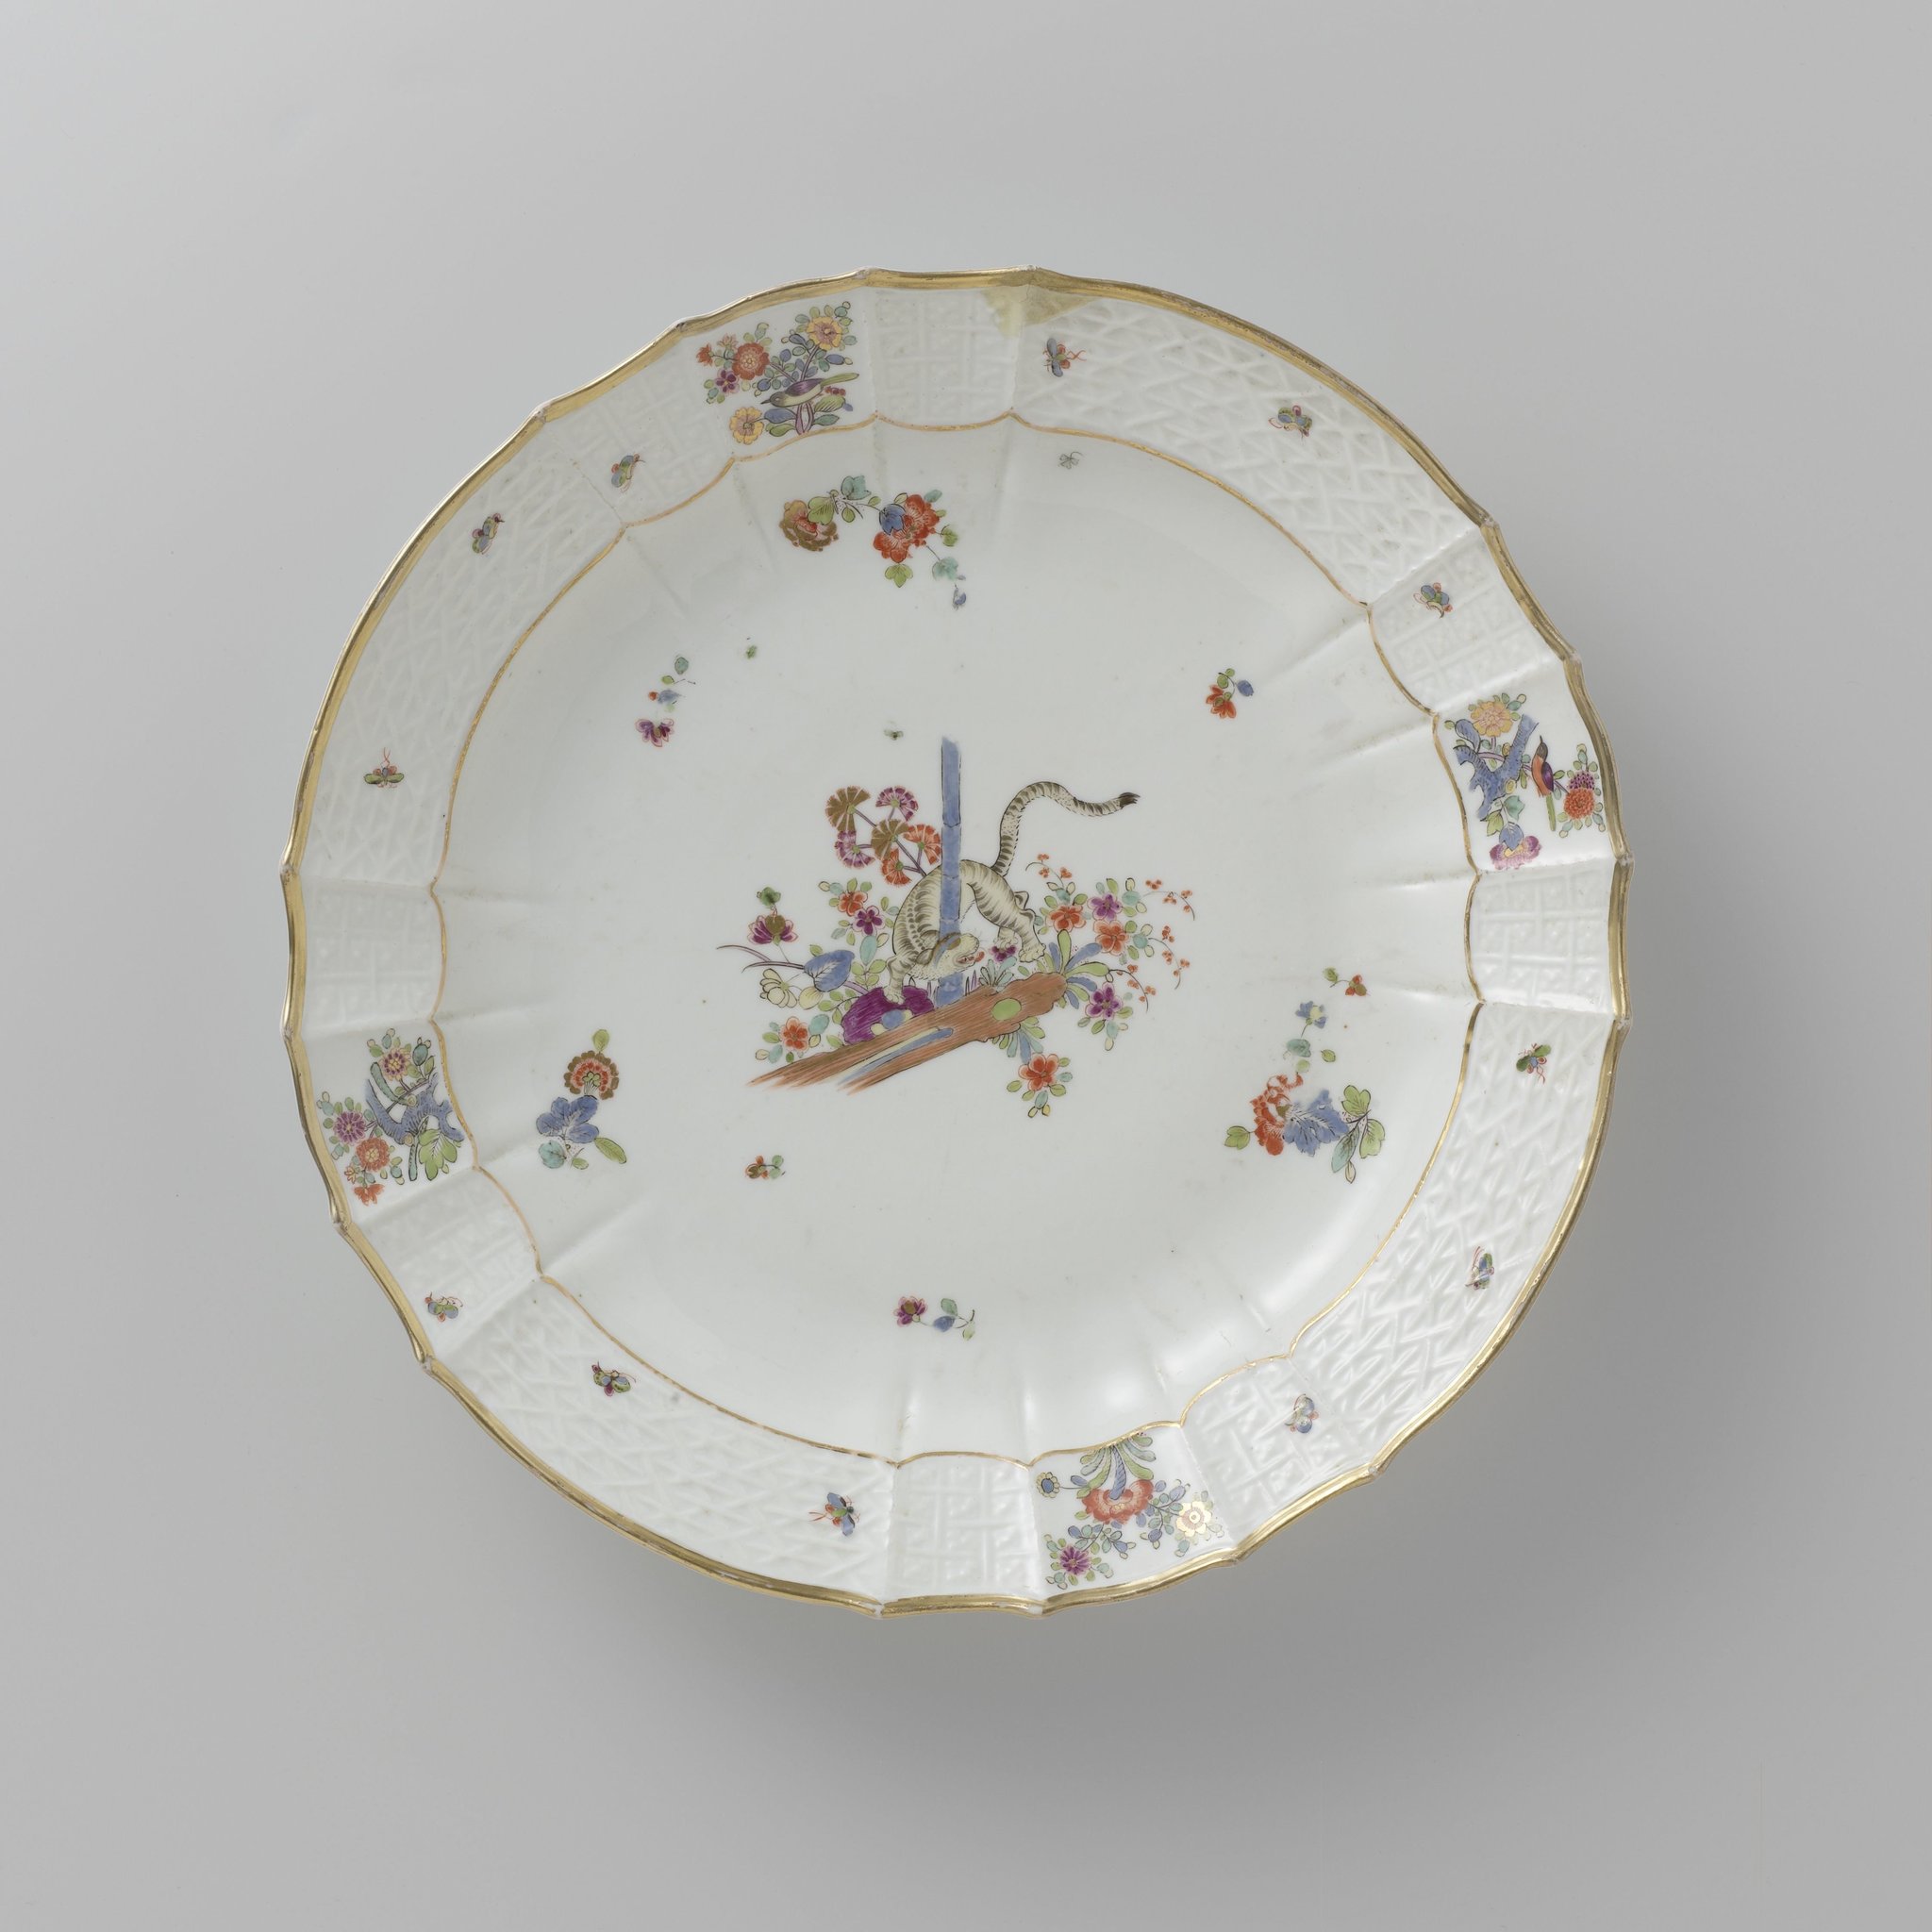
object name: eating drinking utensil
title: Schotel, veelkleurig beschilderd met een Kakiemon-decor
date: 1740-1745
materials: porcelain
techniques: painted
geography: meissen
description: Ronde schotel van beschilderd porselein. De schotel heeft een geribde en geschulpte rand. De schotel is beschilderd met een tijger om een bamboestengel, gestrooide Indianische Blumen, vlinders en takken met vogels. De rand is versierd met het 'Altbrandenstein'-patroon. De schotel is gemerkt.